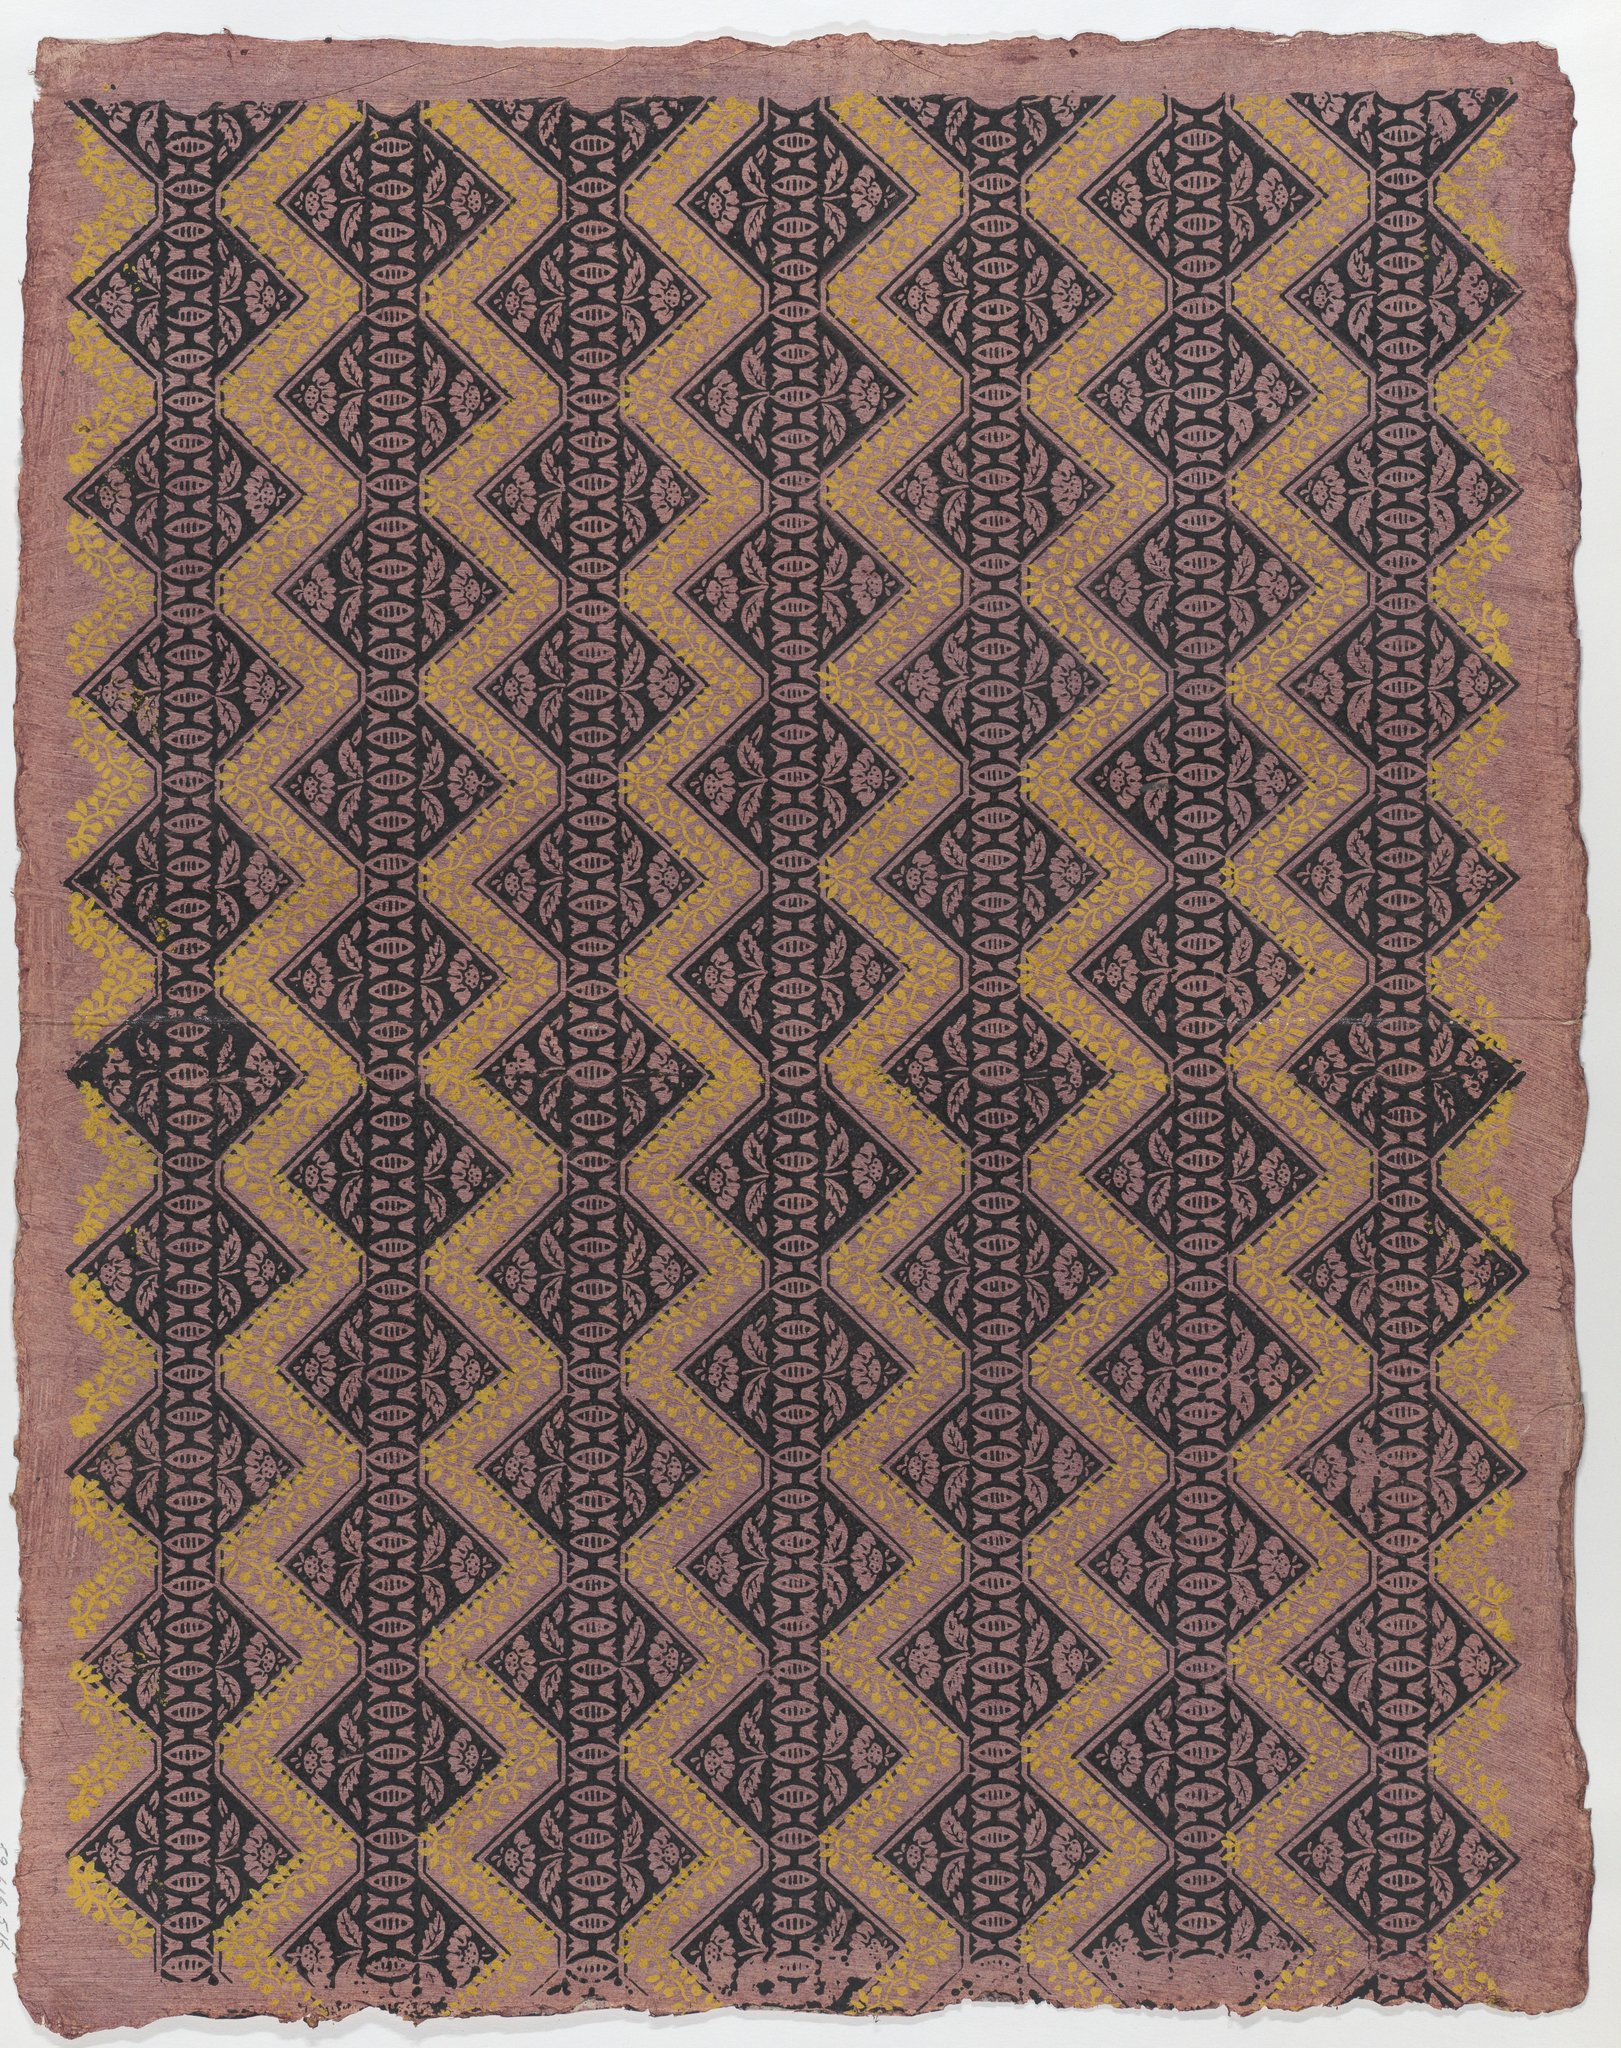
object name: print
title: Sheet with overall floral zig zagging pattern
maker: Anonymous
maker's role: artist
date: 1767-1866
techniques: relief print